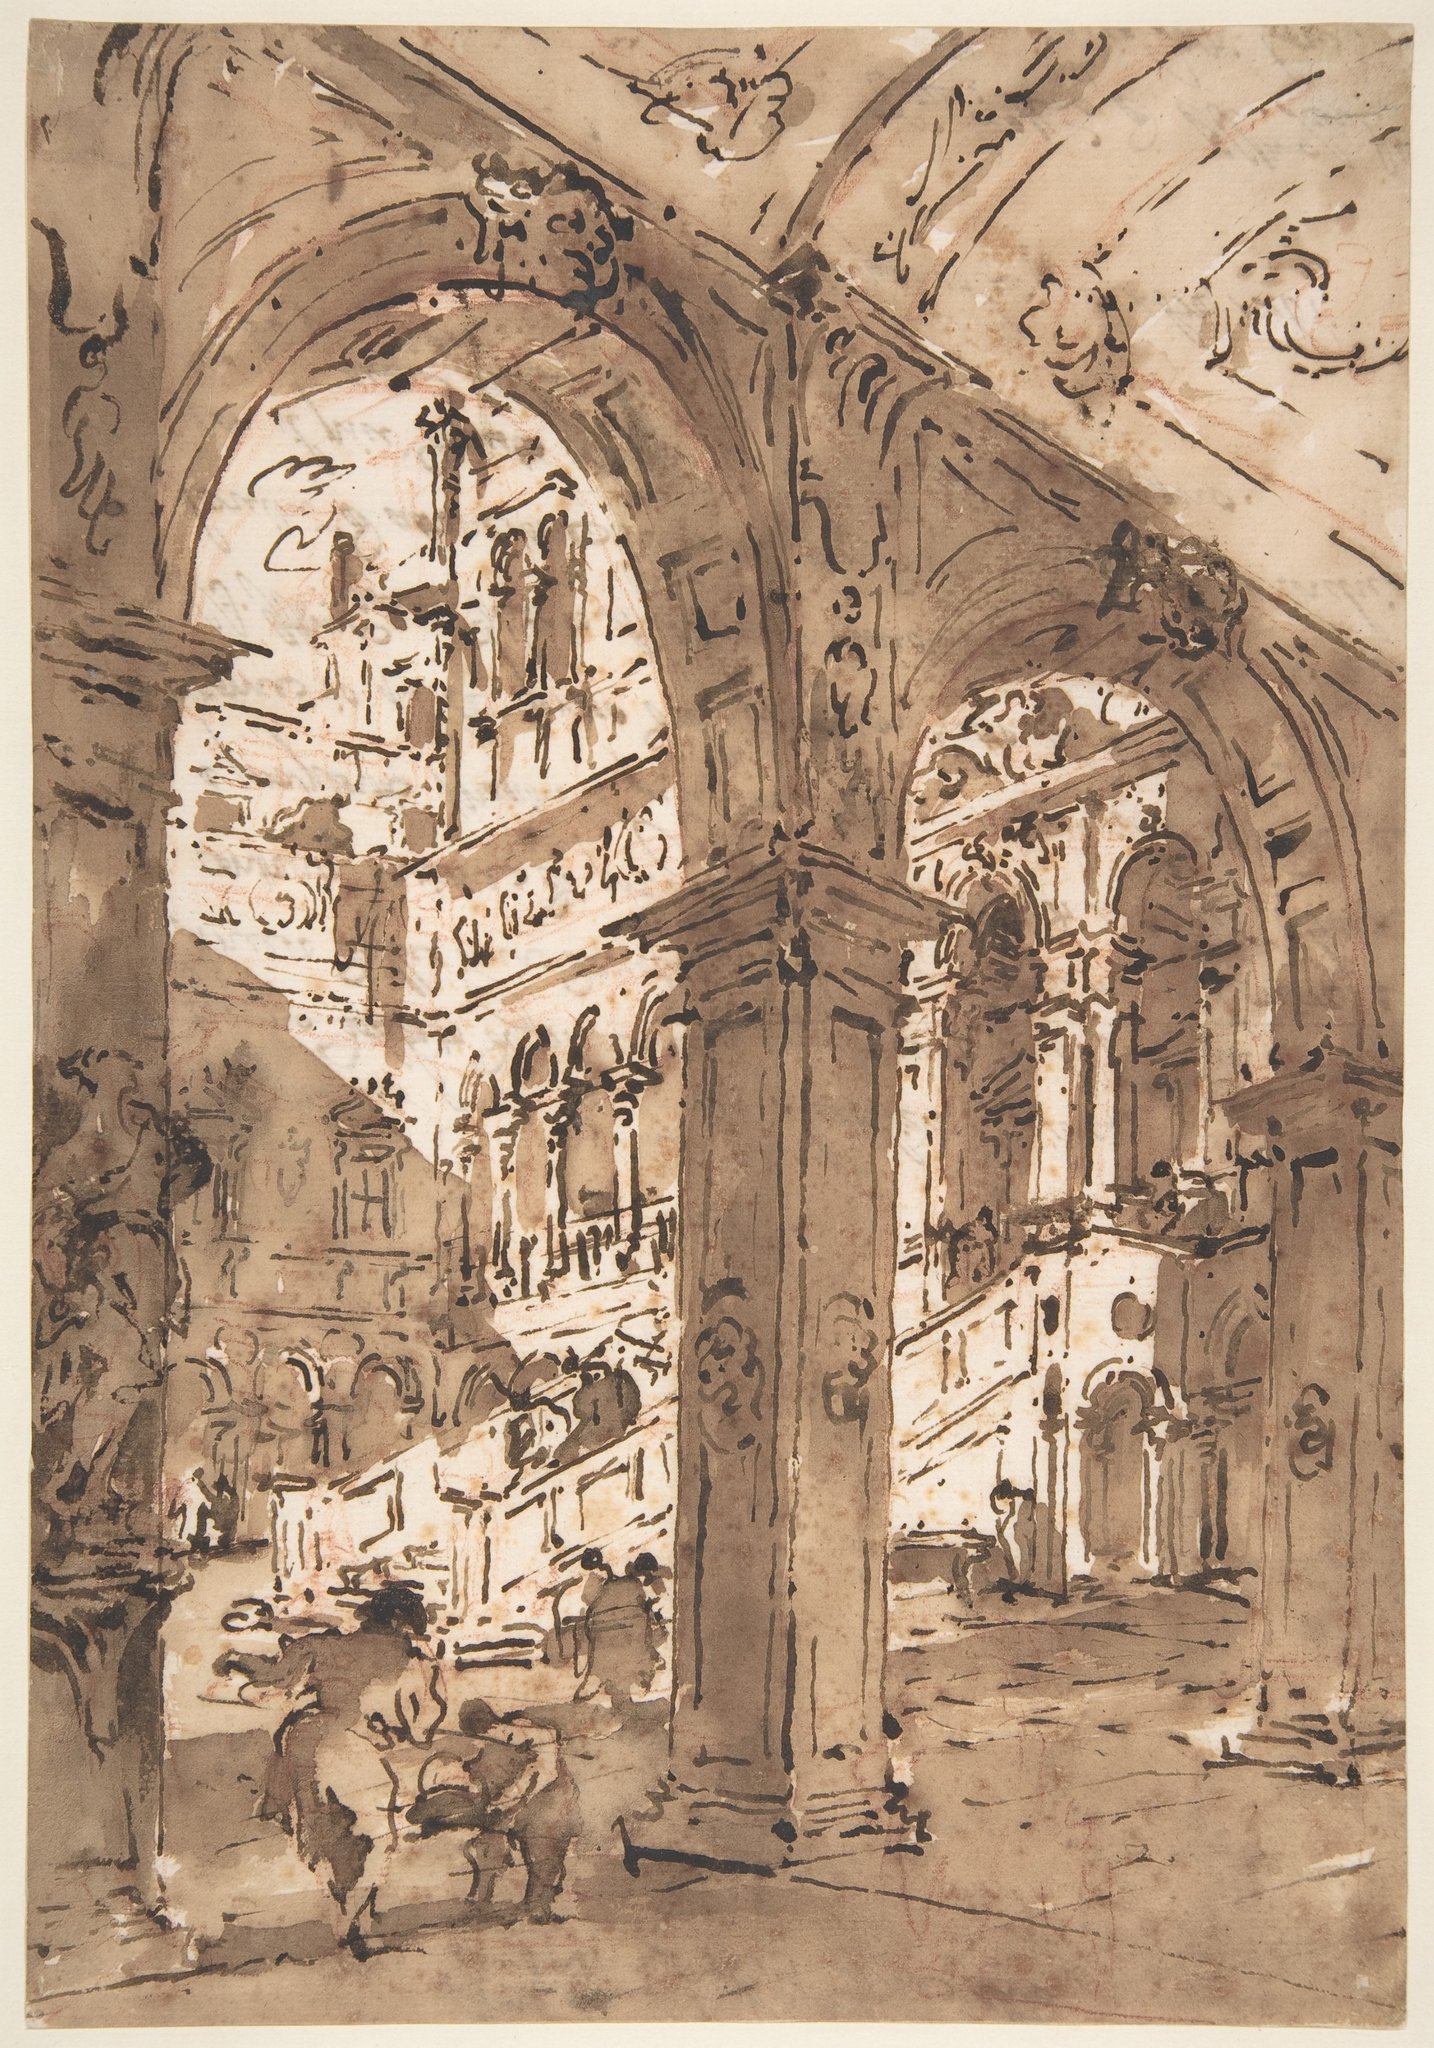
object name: drawing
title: Architectural Capriccio: Courtyard of a Palace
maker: francesco guardi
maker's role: artist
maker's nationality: italian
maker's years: 1712-1793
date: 1712-1793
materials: chalk, ink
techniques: brush, pen, wash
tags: architecture,palaces,courtyards